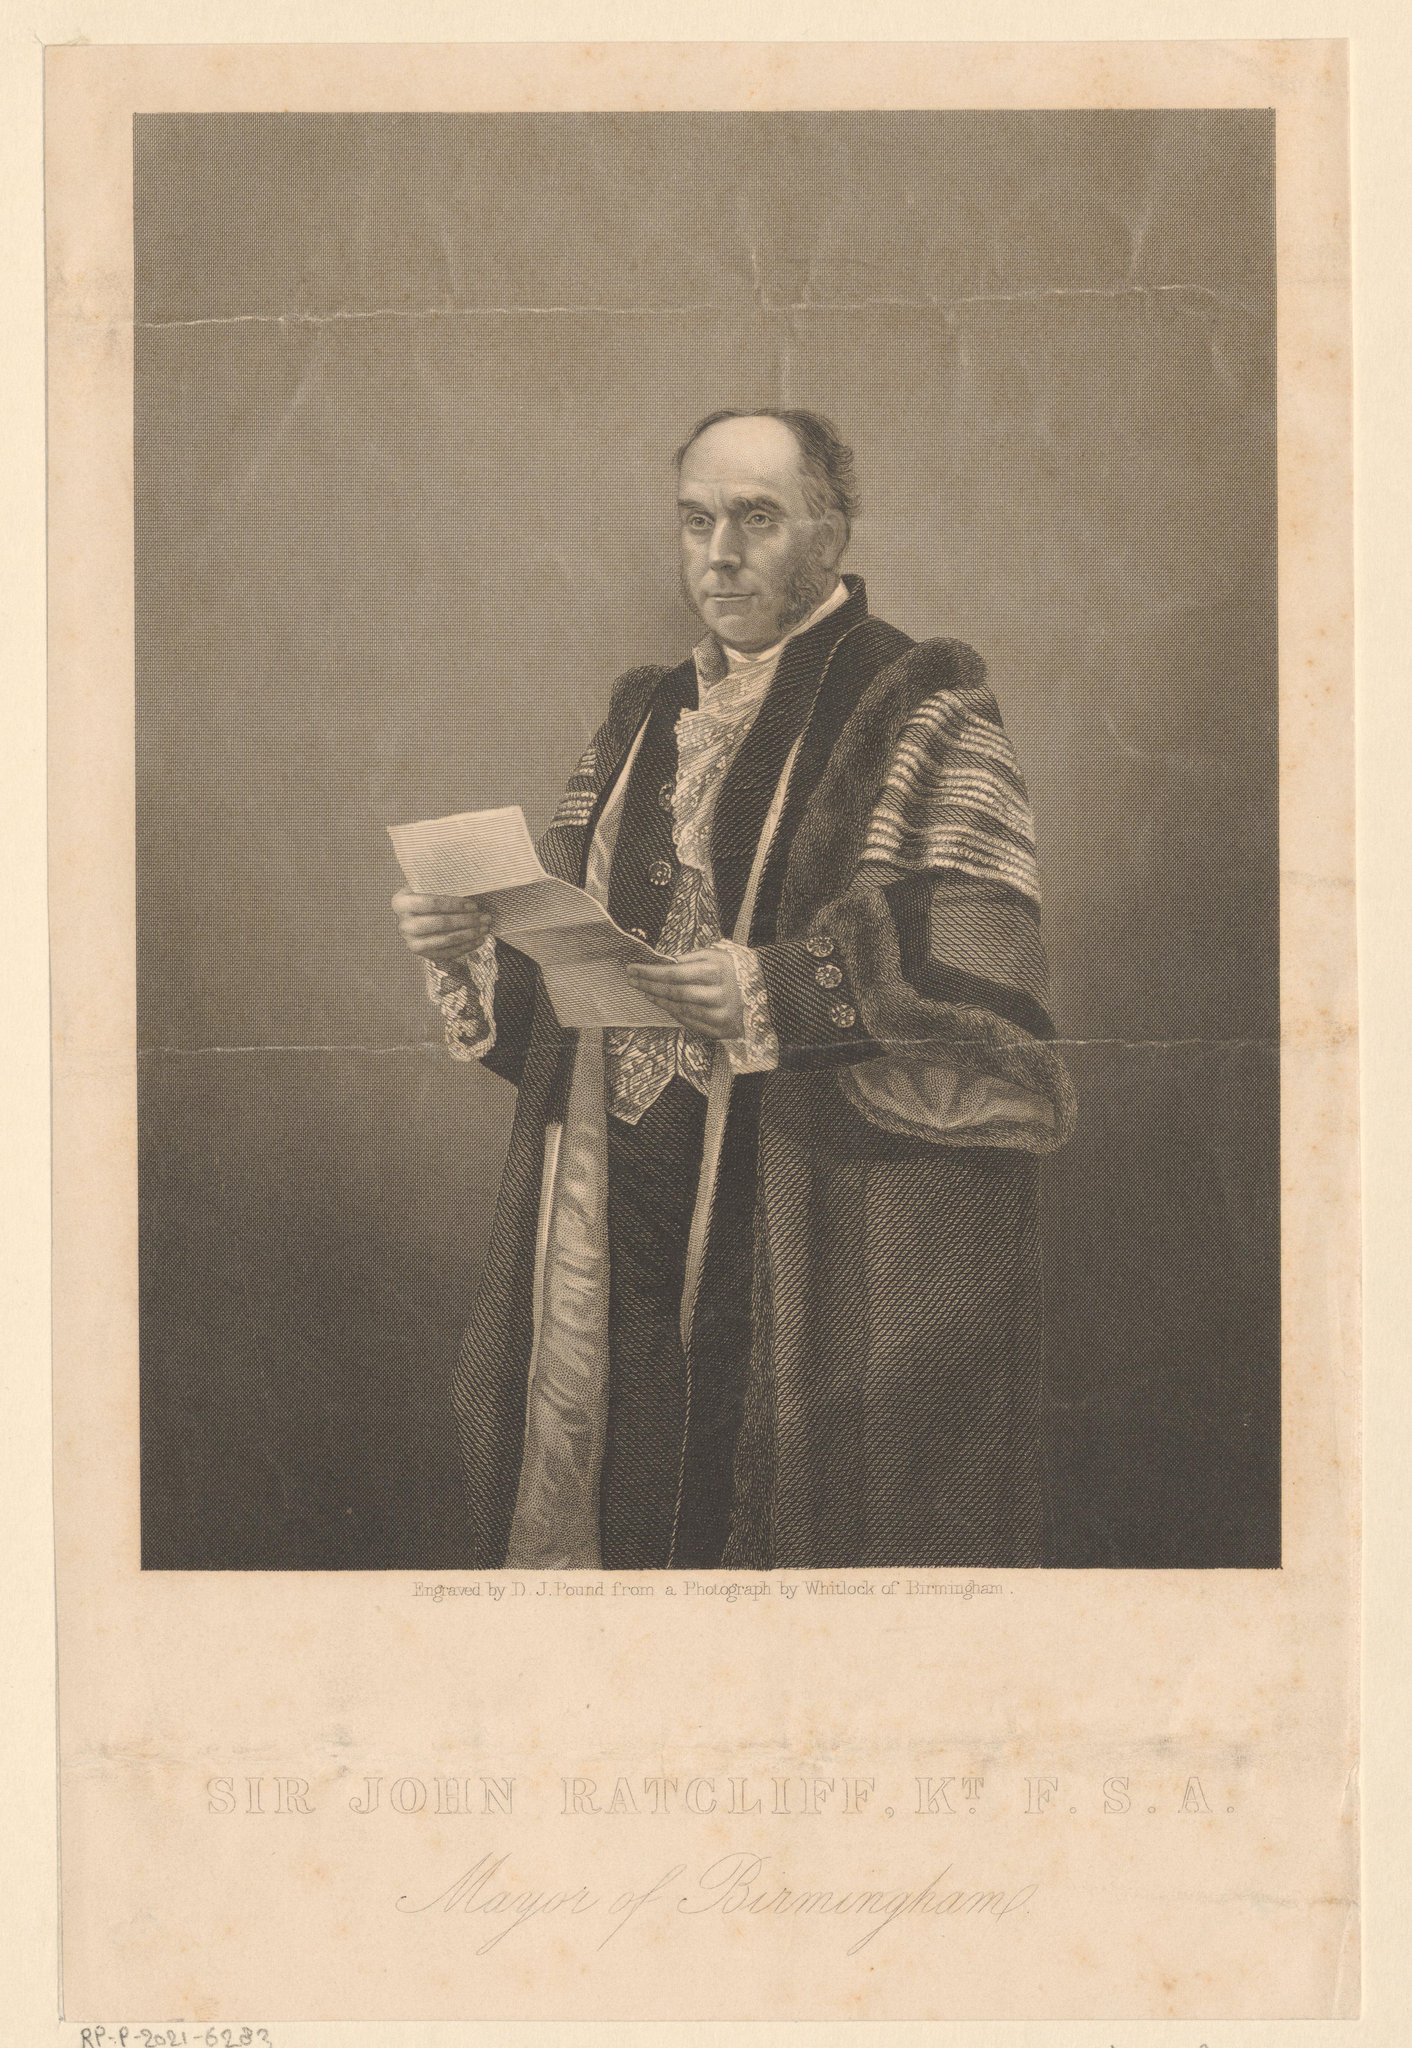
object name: print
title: Portret van John Ratcliffe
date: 1852-1877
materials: paper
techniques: engraving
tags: historical persons